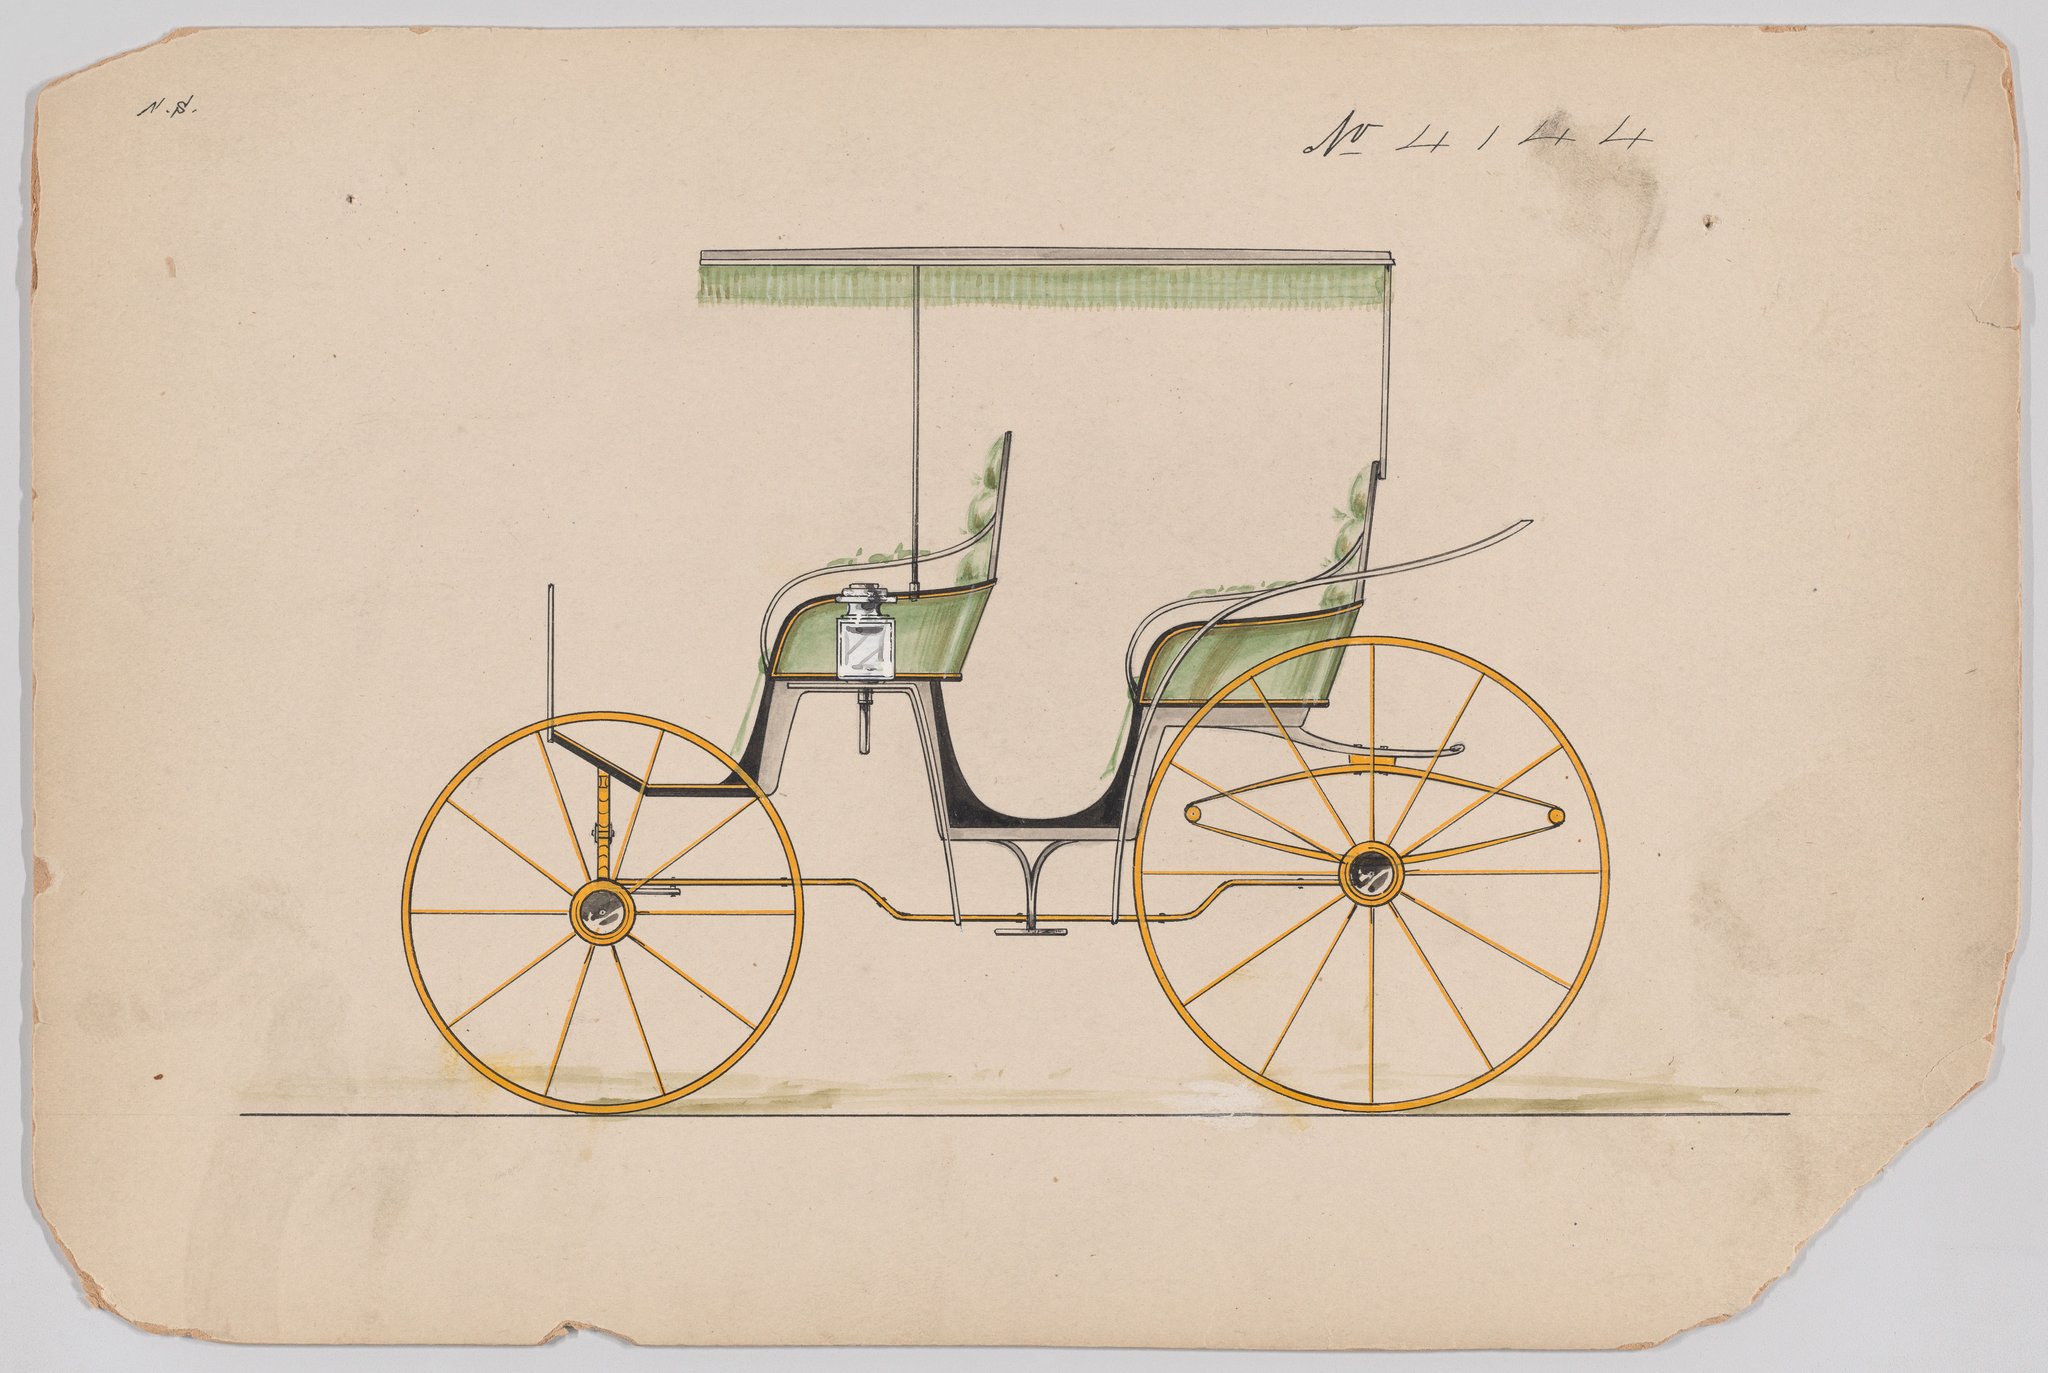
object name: drawing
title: Design for 2 seat Park Phaeton, no. 4144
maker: brewster & co.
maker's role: manufacturer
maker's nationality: american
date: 1891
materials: gouache, ink, watercolor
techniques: pen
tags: carriages